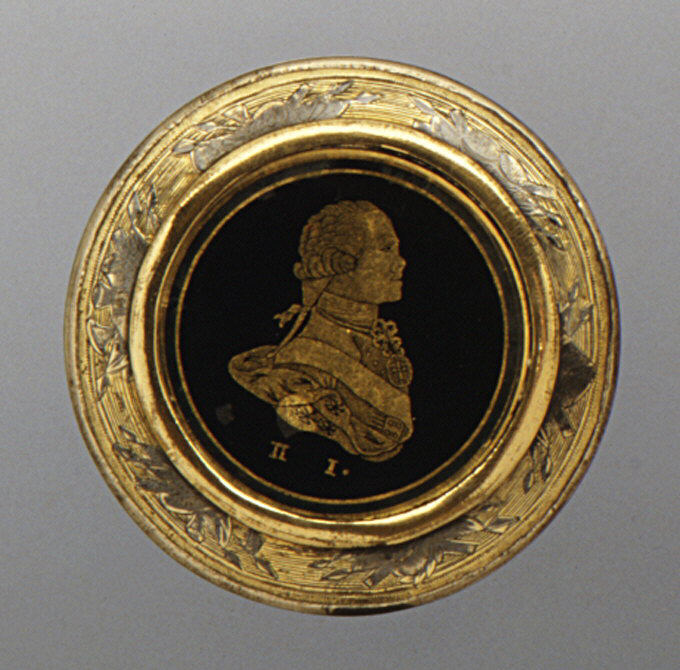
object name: box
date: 1800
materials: niello, silver gilt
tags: men,profiles